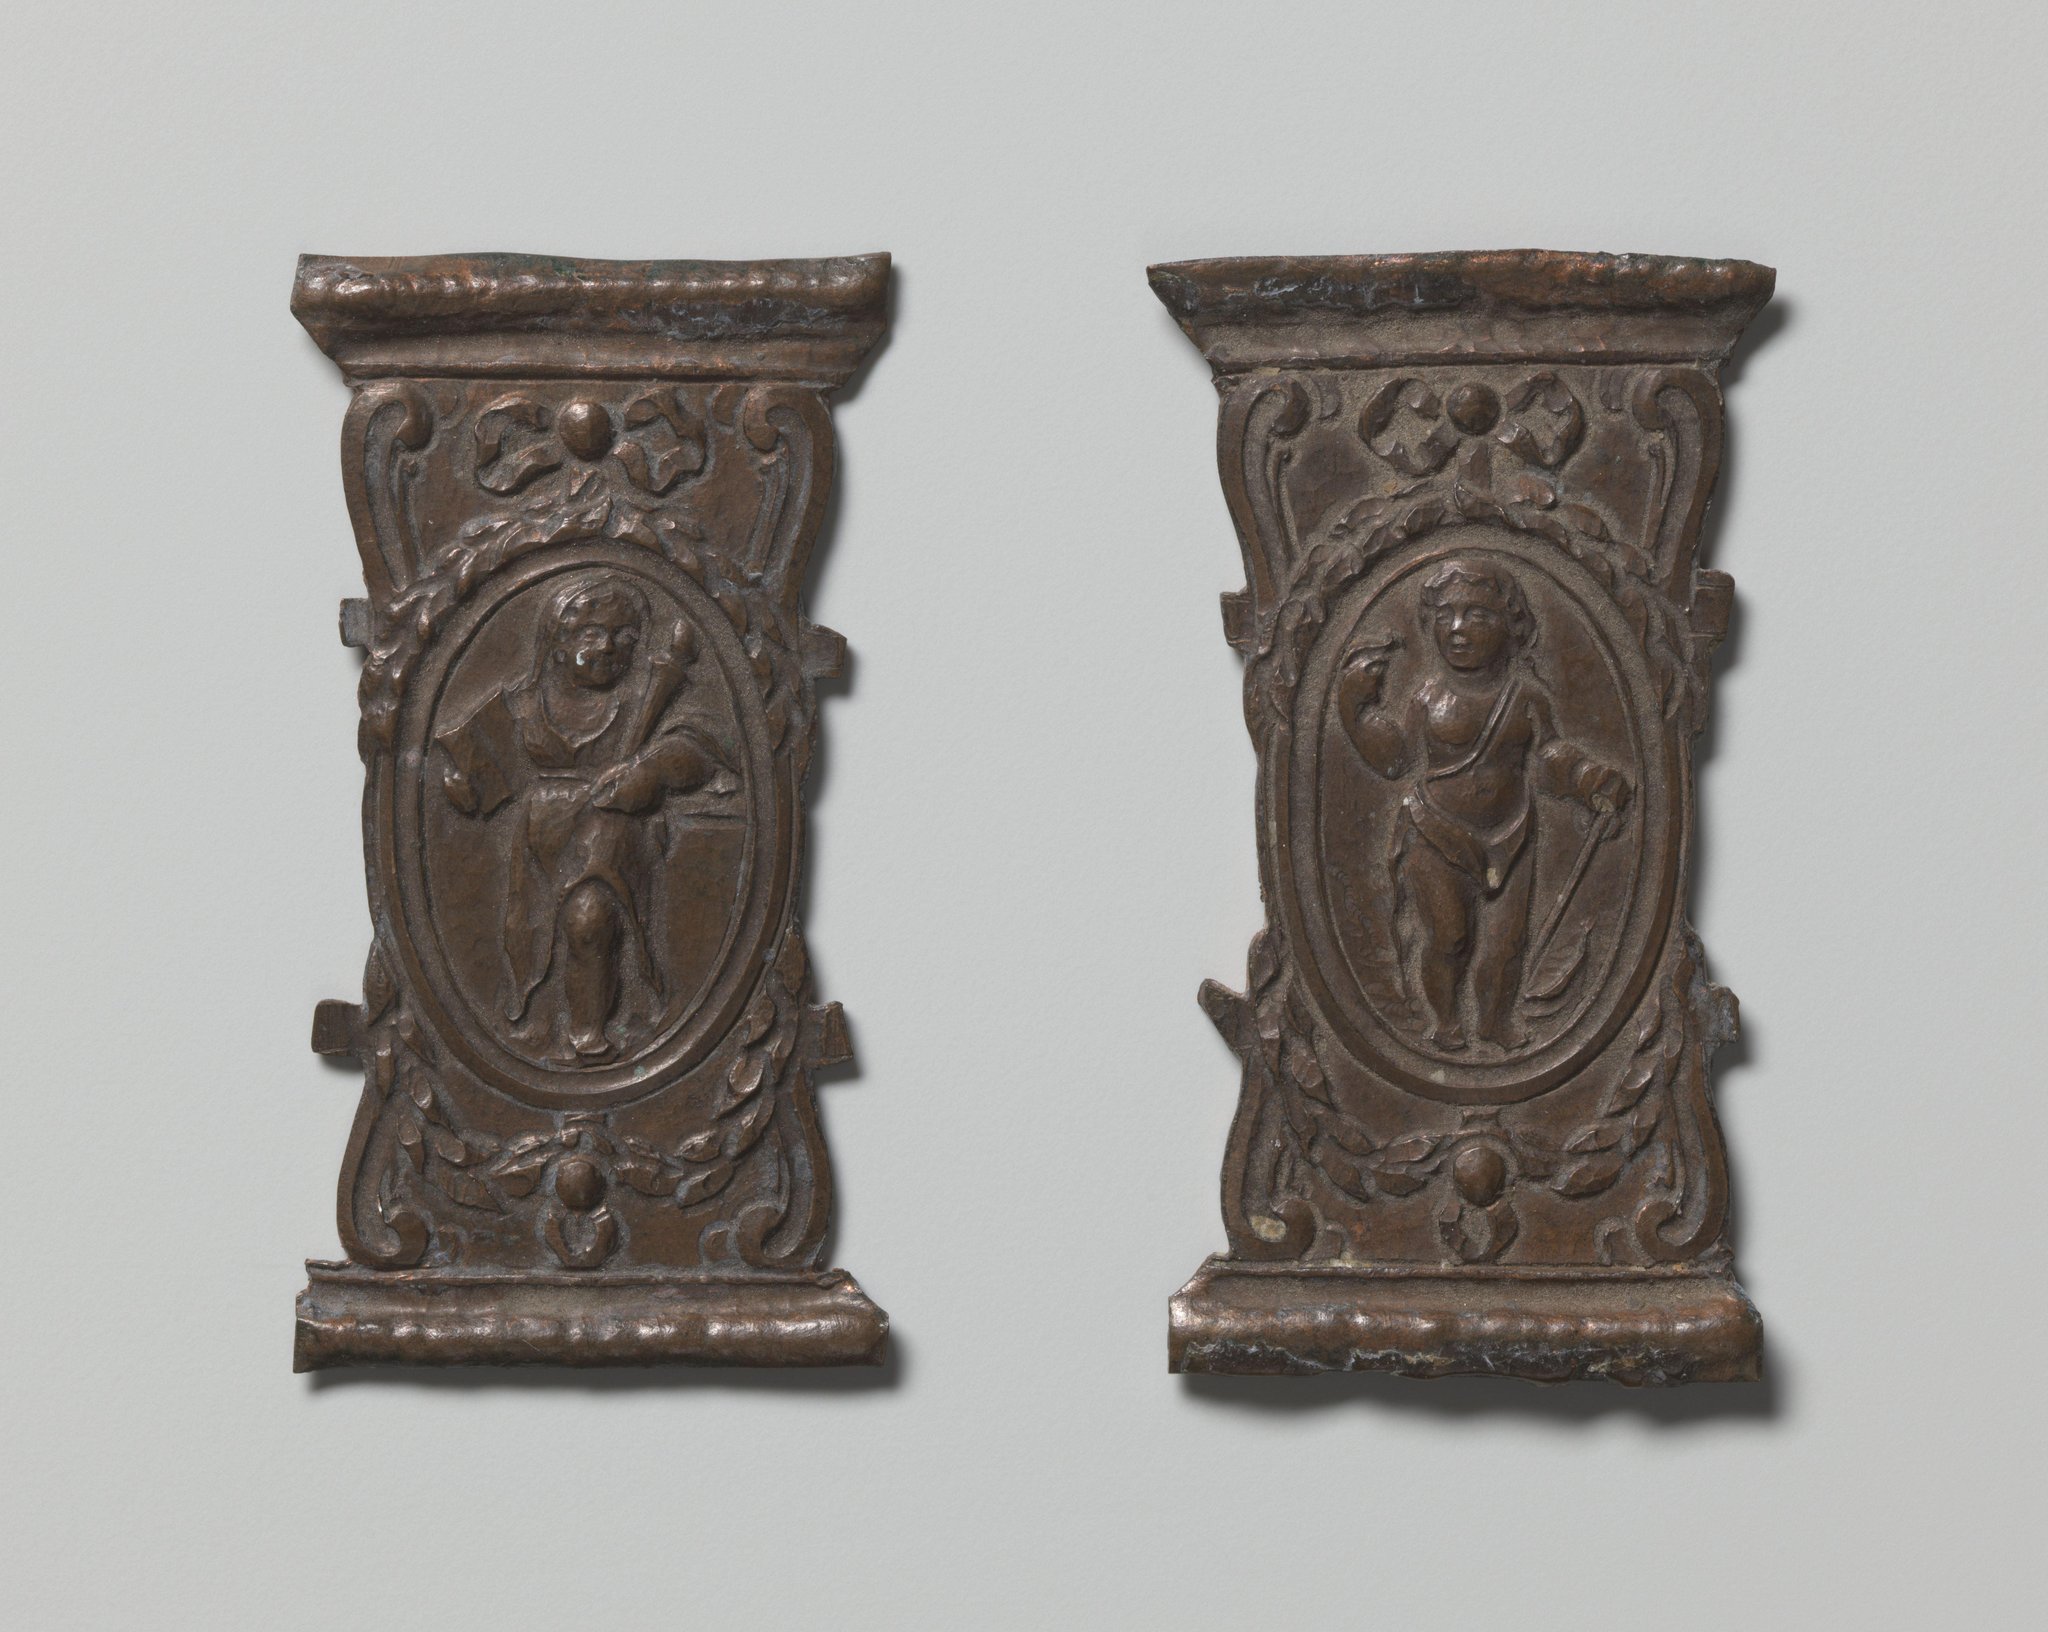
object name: model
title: Modellen voor beugels van een boekslot met een kind met een fakkel en een boek en een jongen met een anker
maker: Anonymous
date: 1750-1775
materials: copper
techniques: repoussé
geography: amsterdam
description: De uit plaat gedreven modellen voor een gietvorm zijn versierd met medaillons, welke door een strik en een guirlande zijn omgeven. Beugel A geeft een kind met een fakkel en een boek weer en beugel B een kind met een anker.